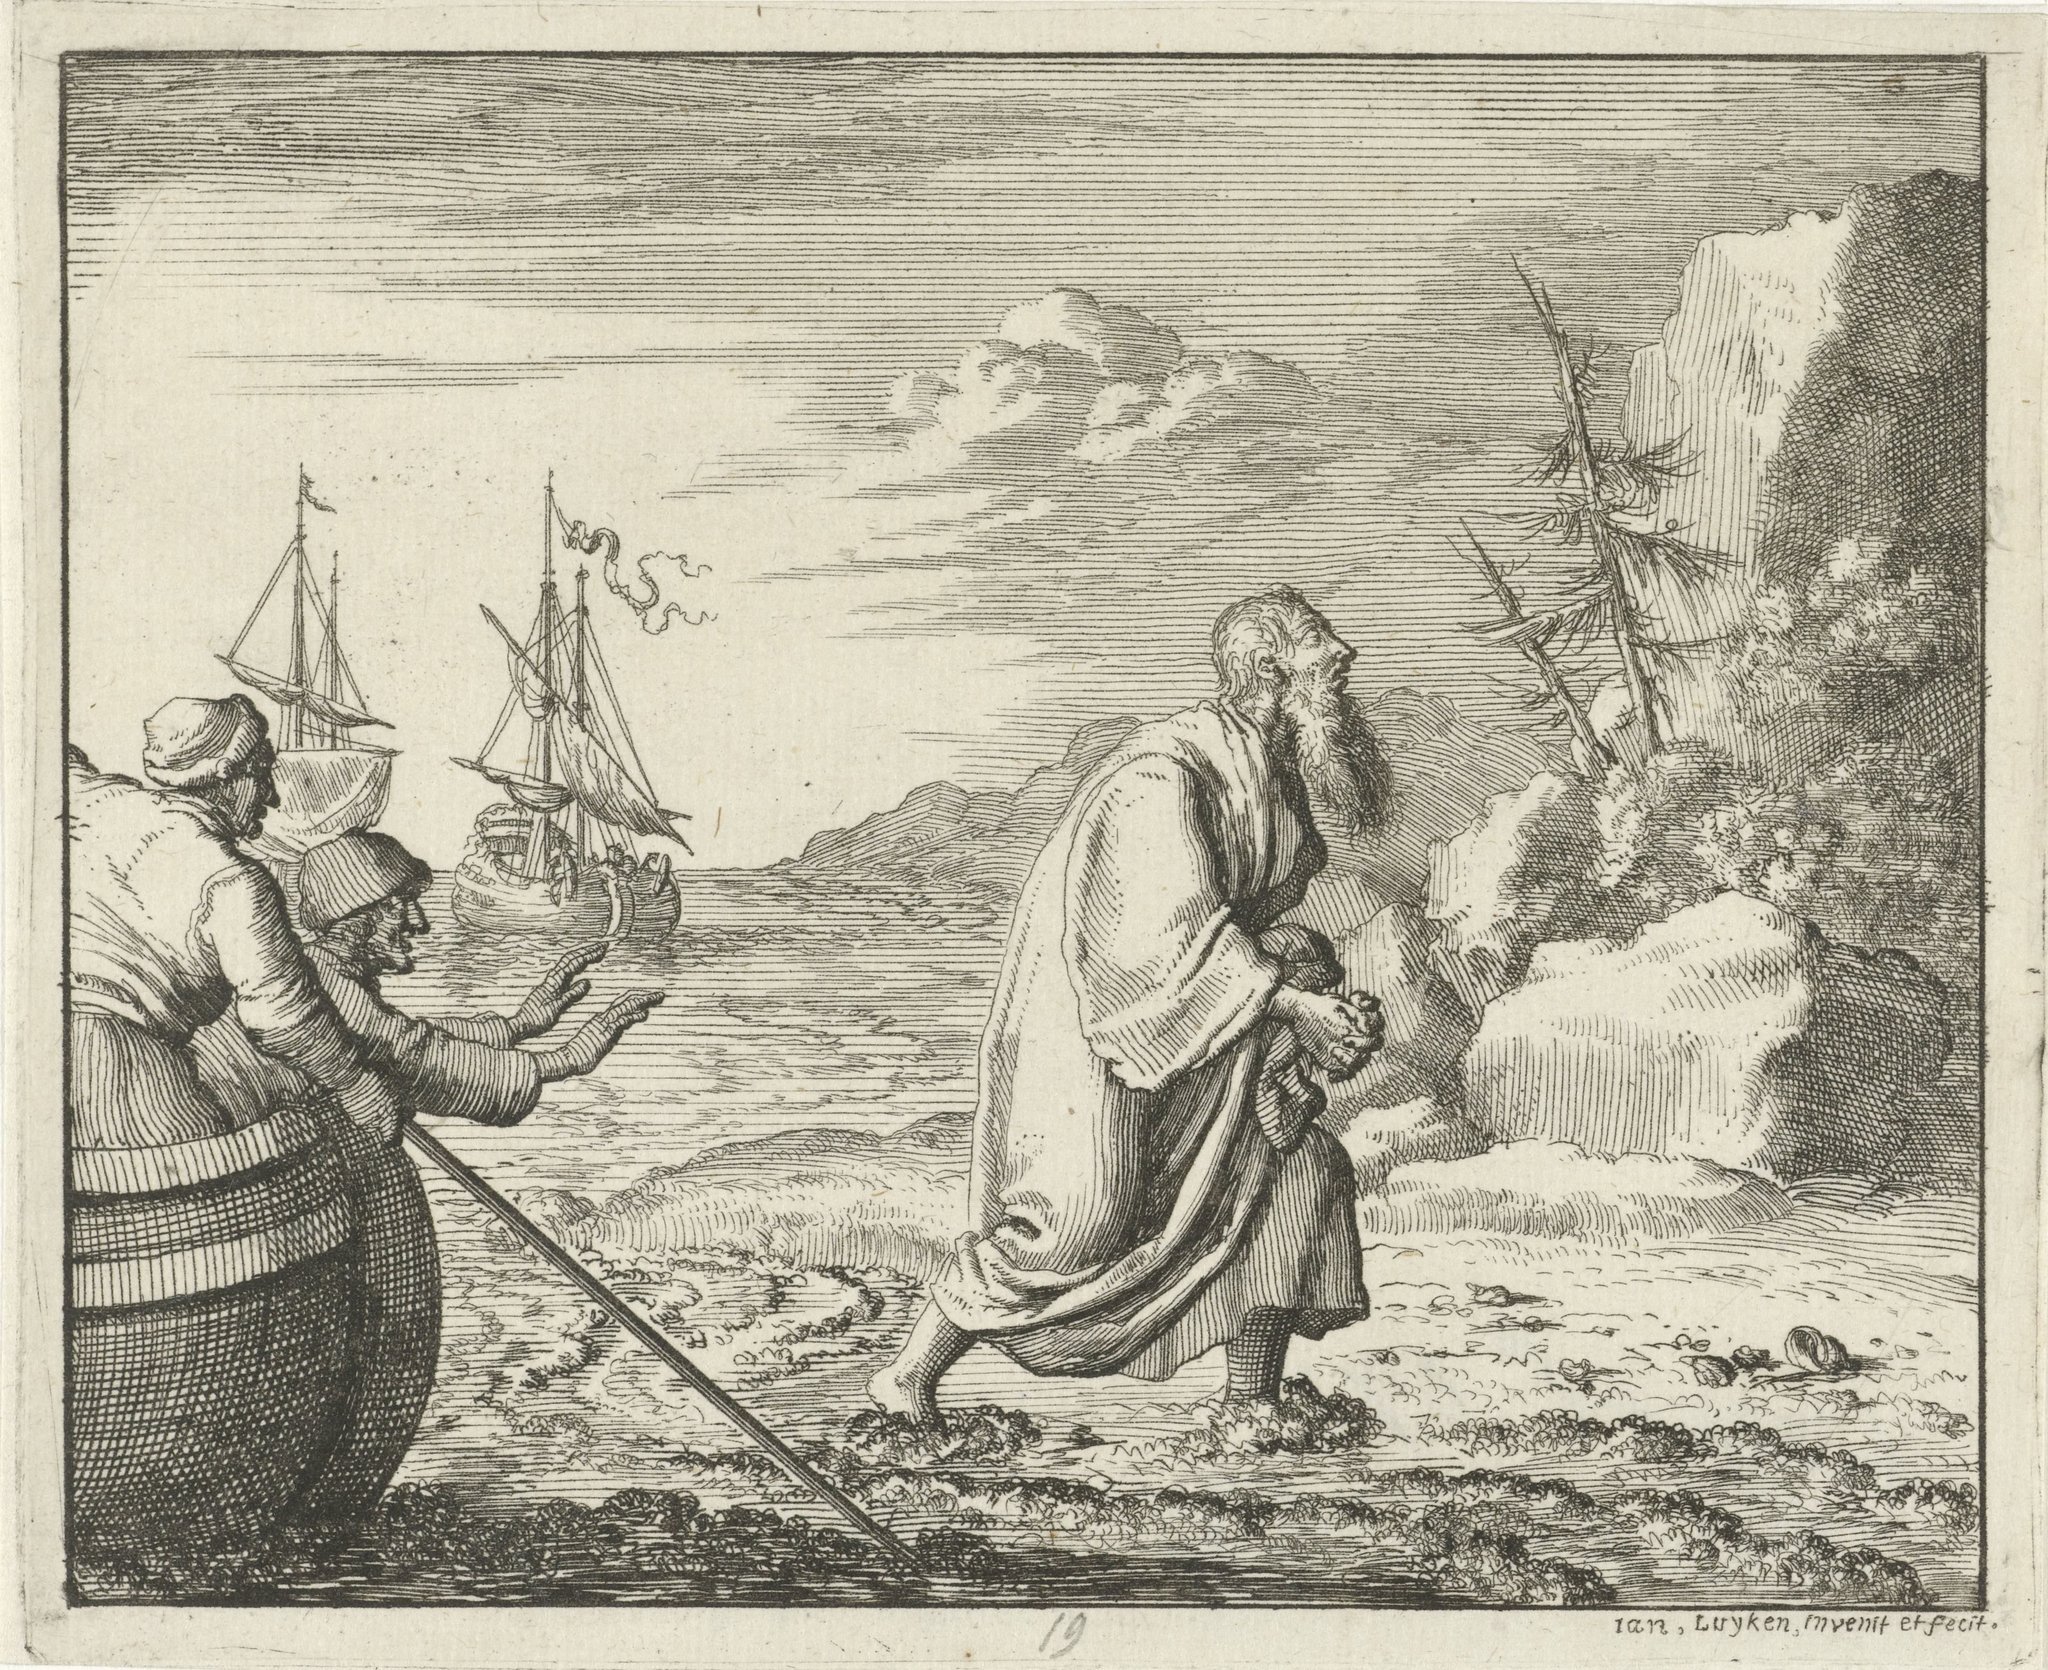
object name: book illustration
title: Johannes de evangelist naar Patmos verbannen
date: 1685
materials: paper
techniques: etching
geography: amsterdam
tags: john (writing) on the island of patmos, possibly the eagle beside him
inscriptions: collector's mark: Lugt 2228, number: ‘19’